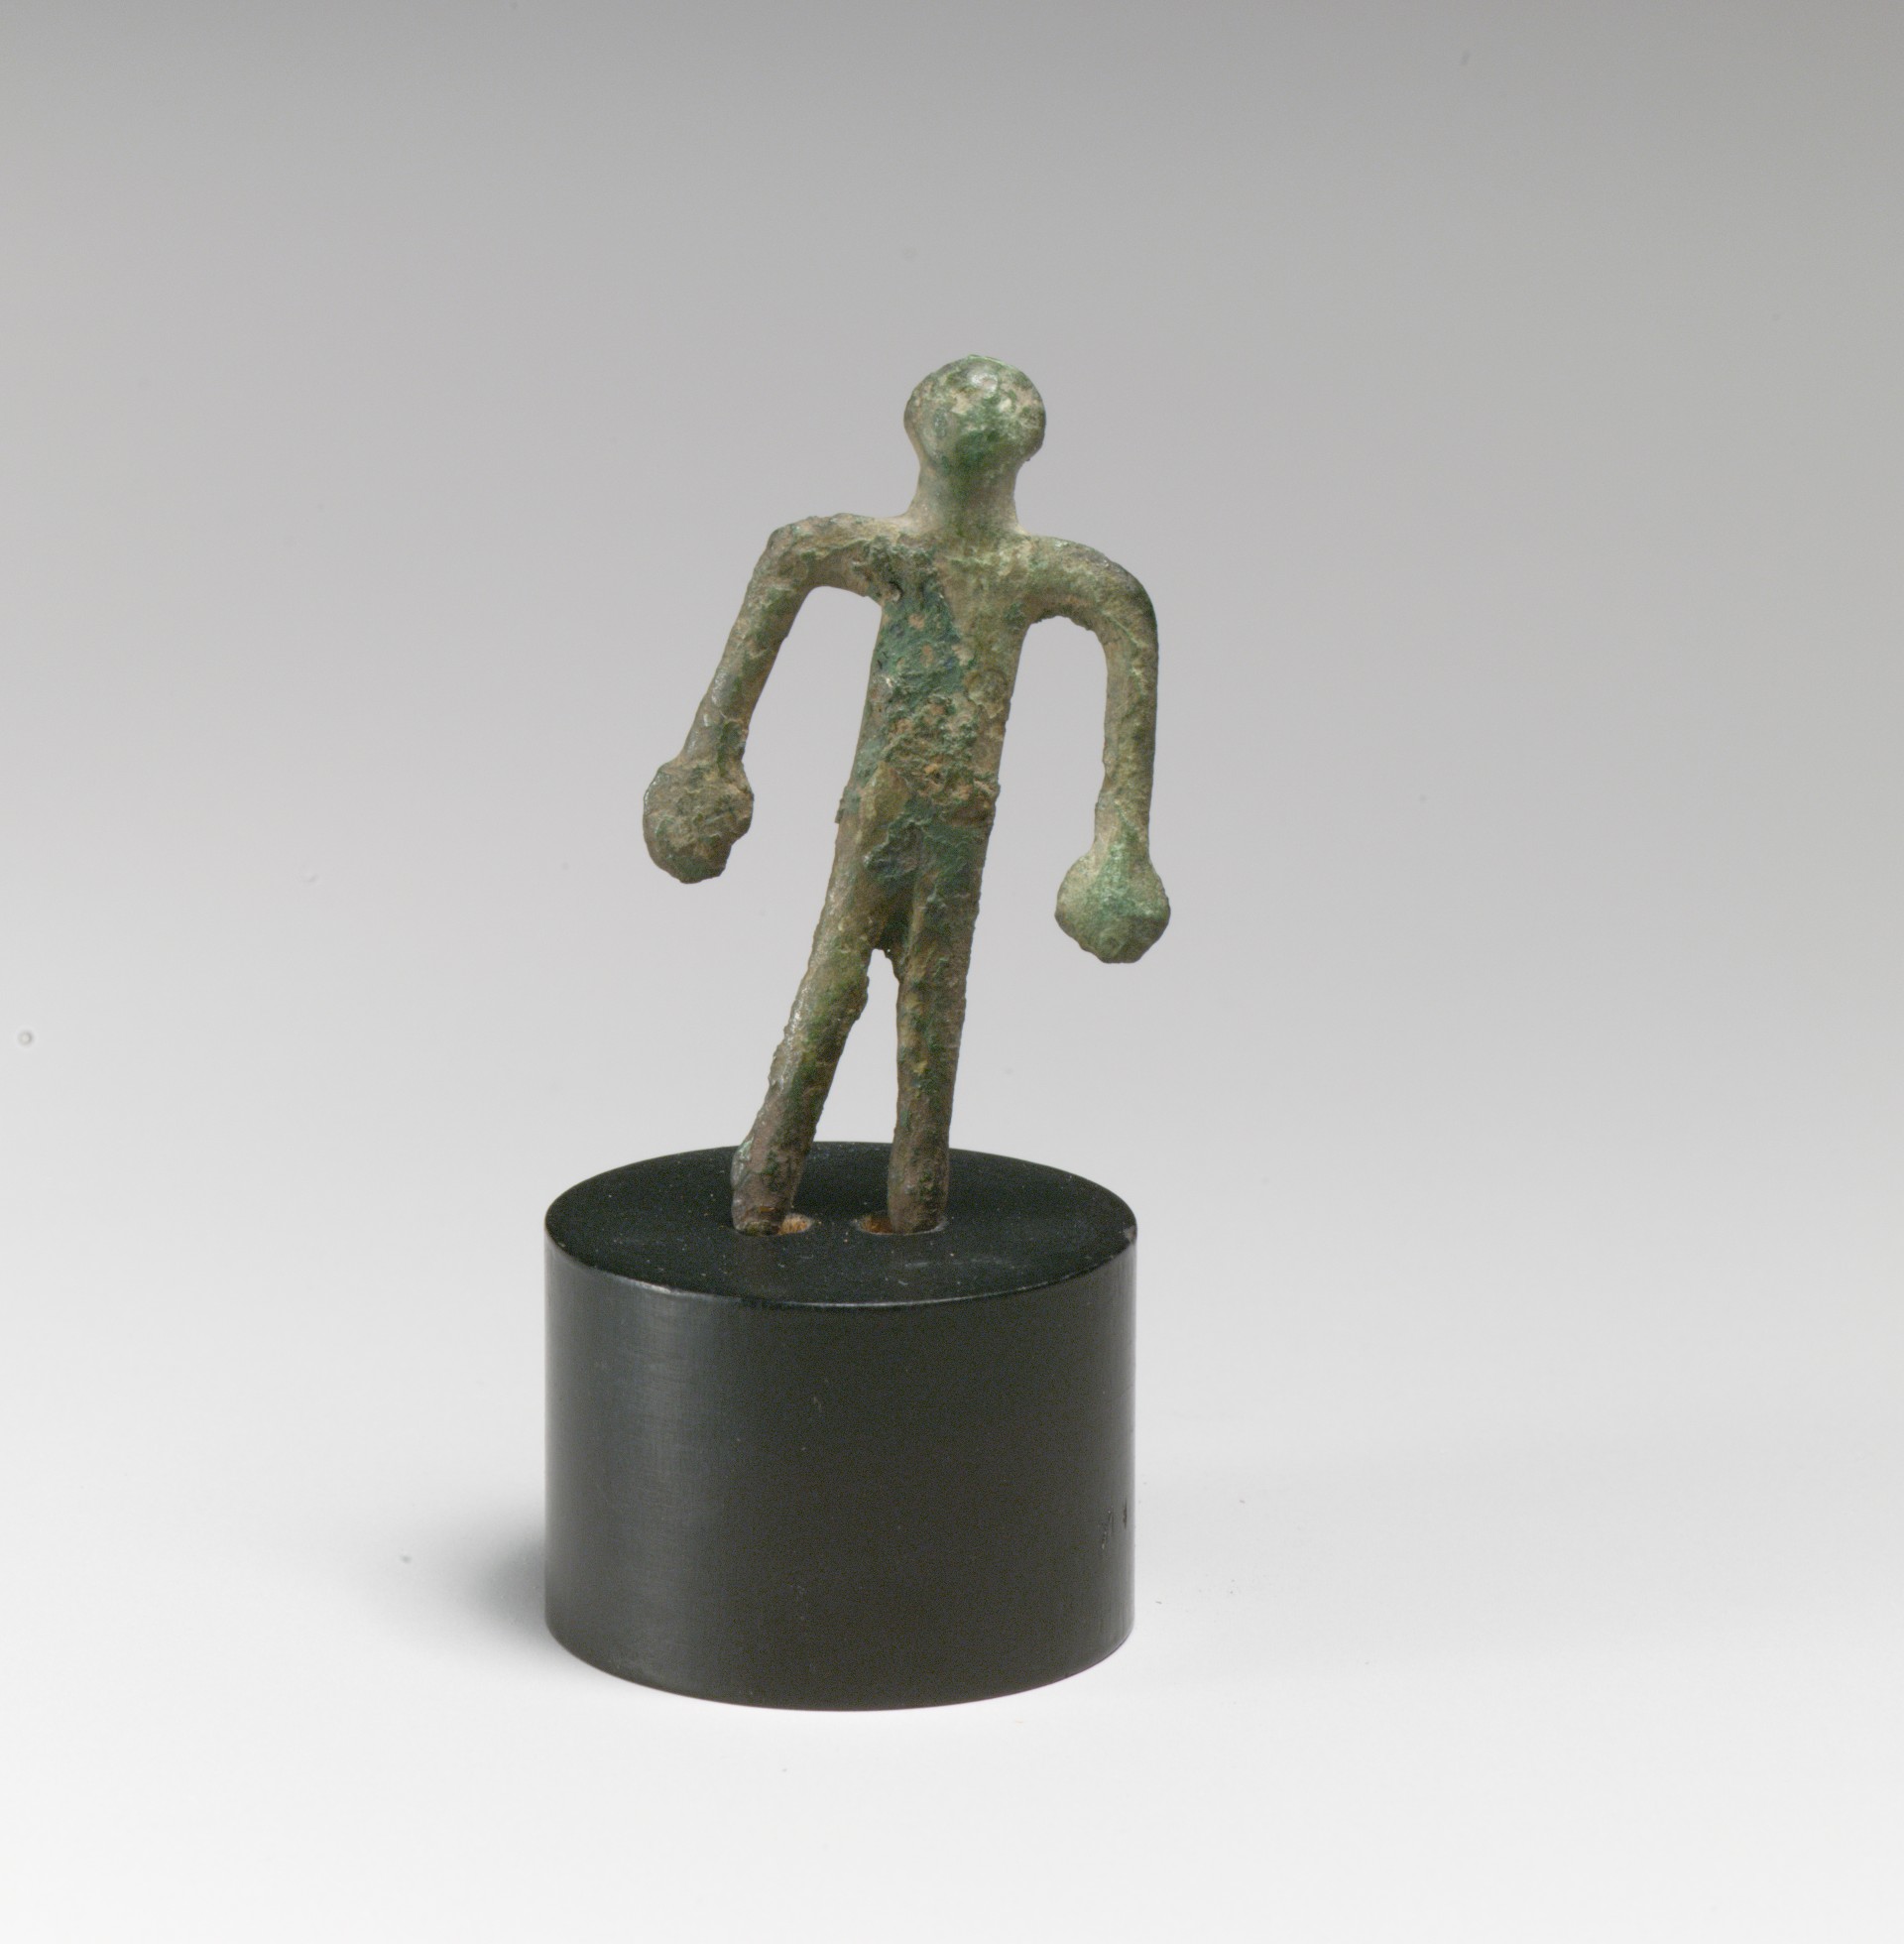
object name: statuette of a woman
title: Statuette of a woman ?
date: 7000 BCE-330 CE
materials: bronze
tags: women